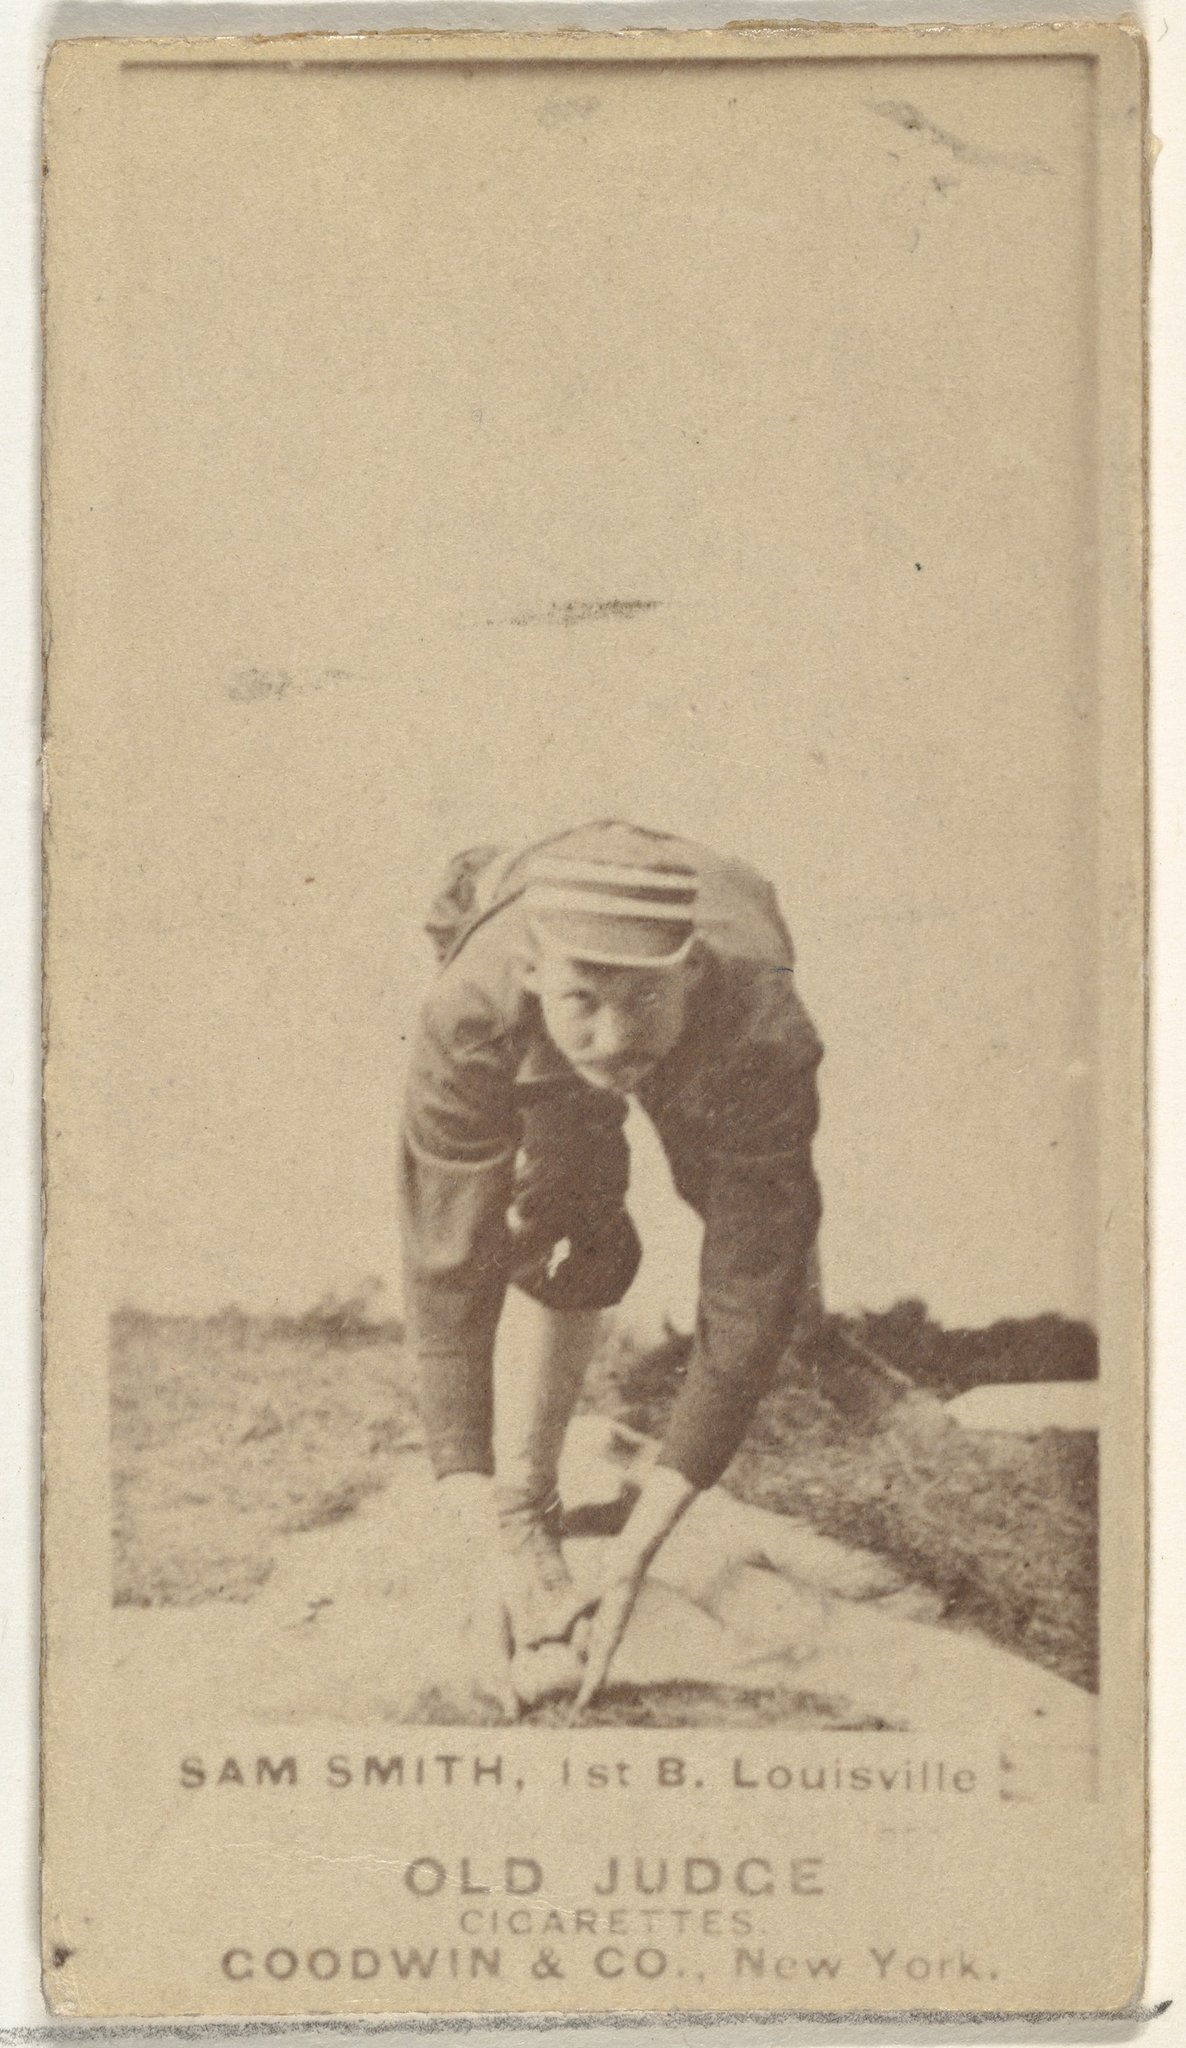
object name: baseball card, photograph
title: Samuel J. "Skyrocket" Smith, 1st Base, Louisville Colonels, from the Old Judge series (N172) for Old Judge Cigarettes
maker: goodwin & company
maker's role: publisher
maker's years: 1850-1950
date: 1887-1890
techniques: albumen silver print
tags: men,portraits,baseball,athletes